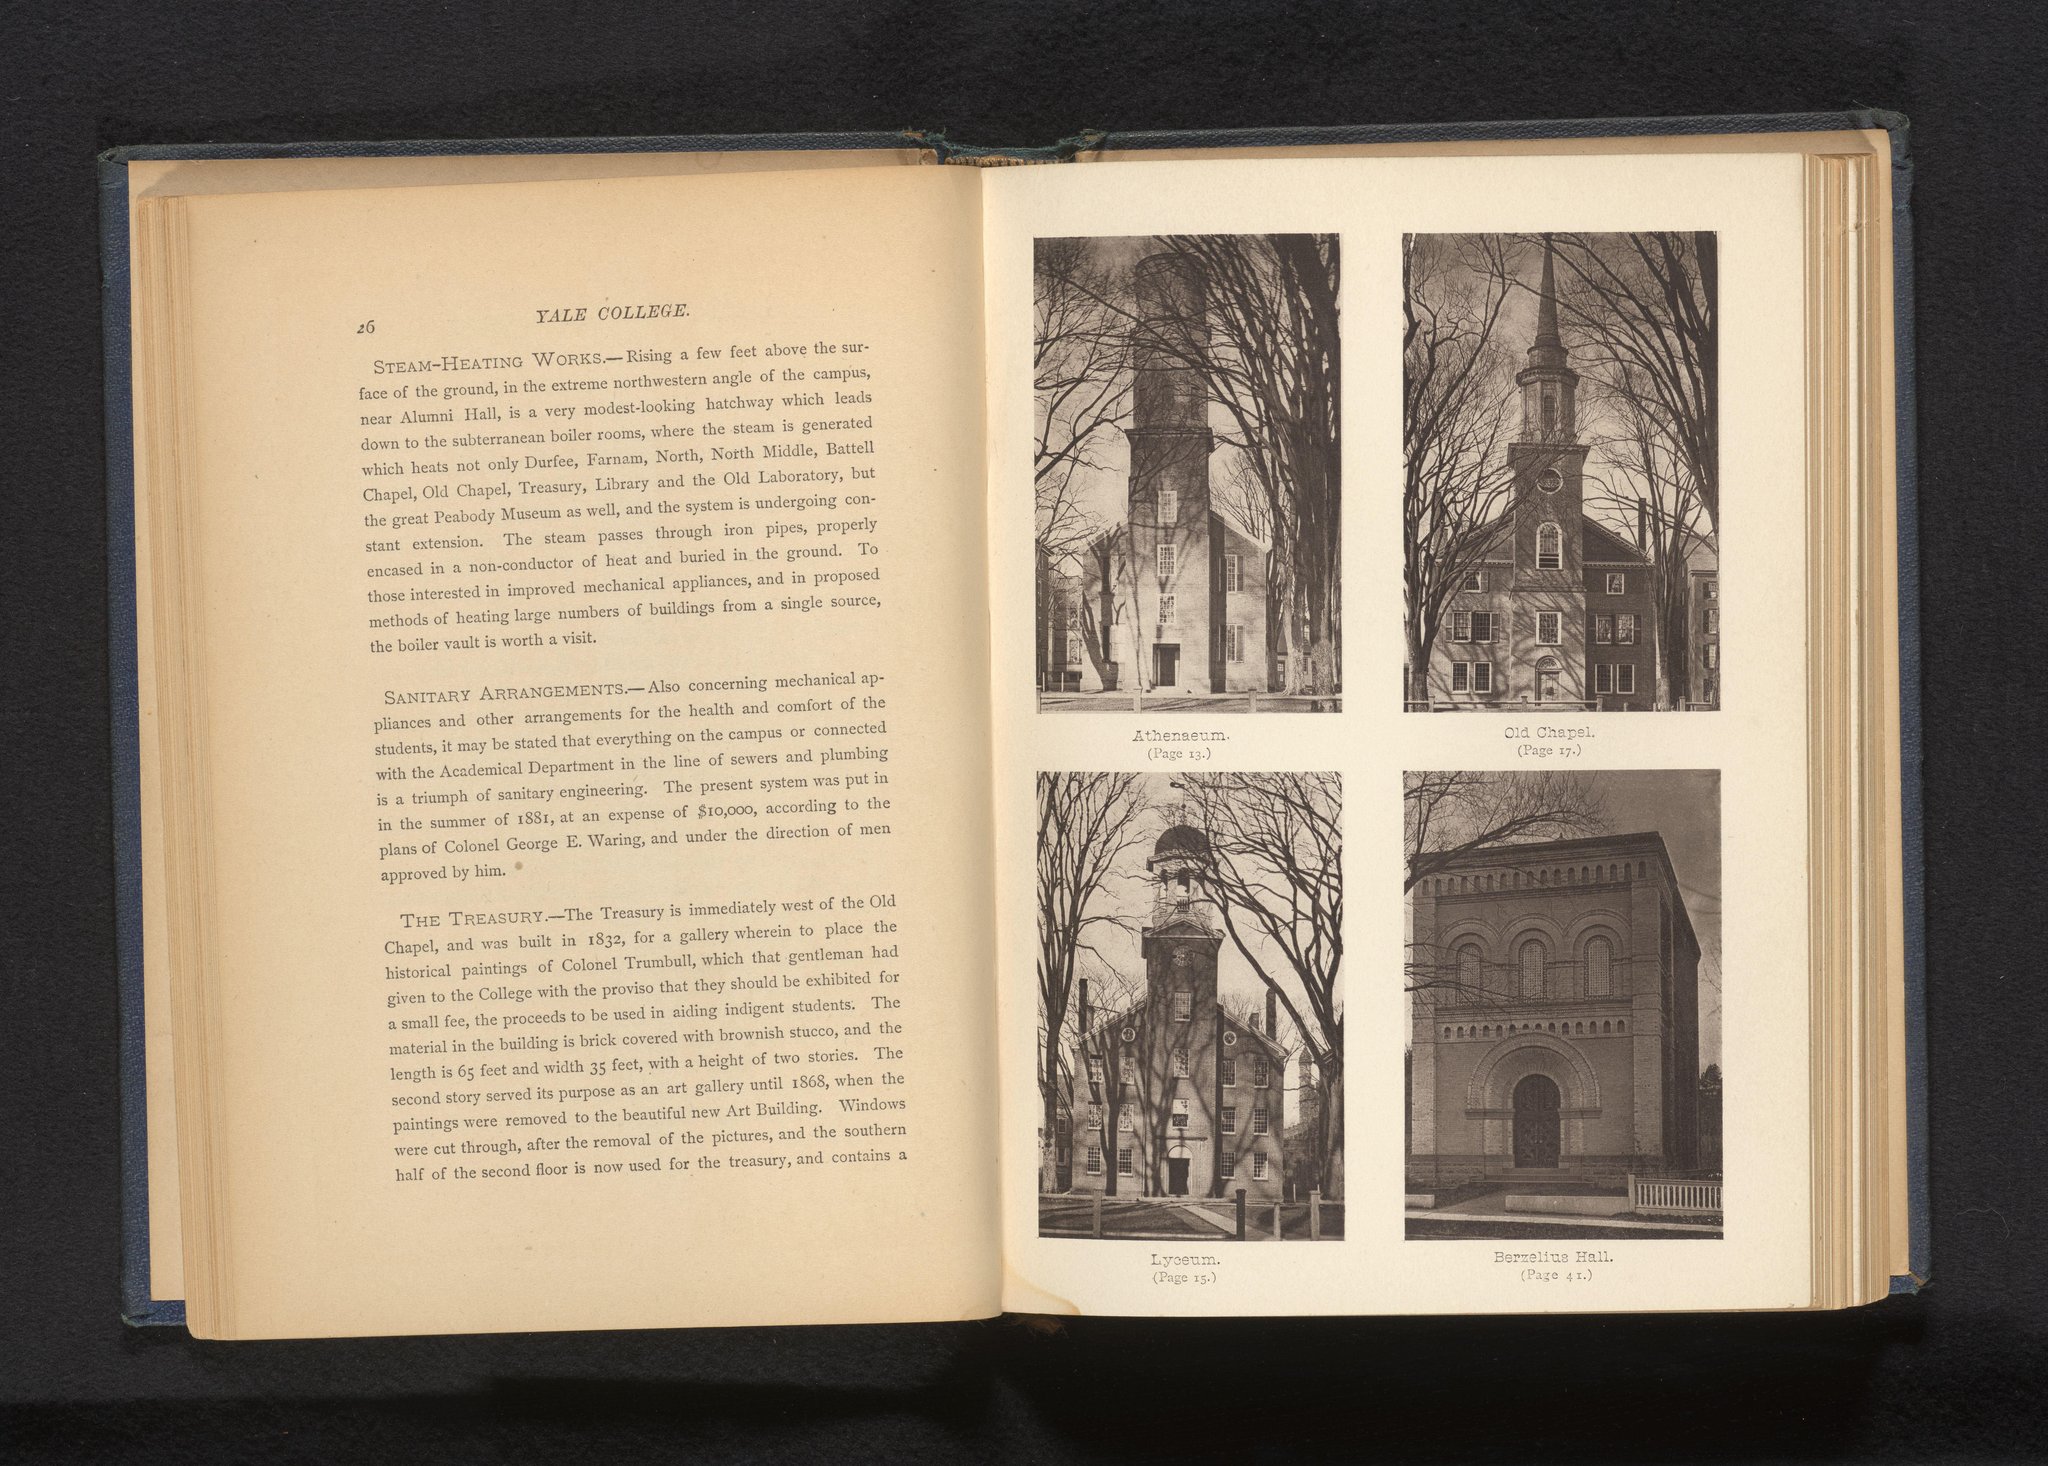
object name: photomechanical print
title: Old chapel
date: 1872-1882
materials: paper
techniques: photograph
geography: new haven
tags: parts of church exterior and annexes: chapel, university, façade (of house or building)